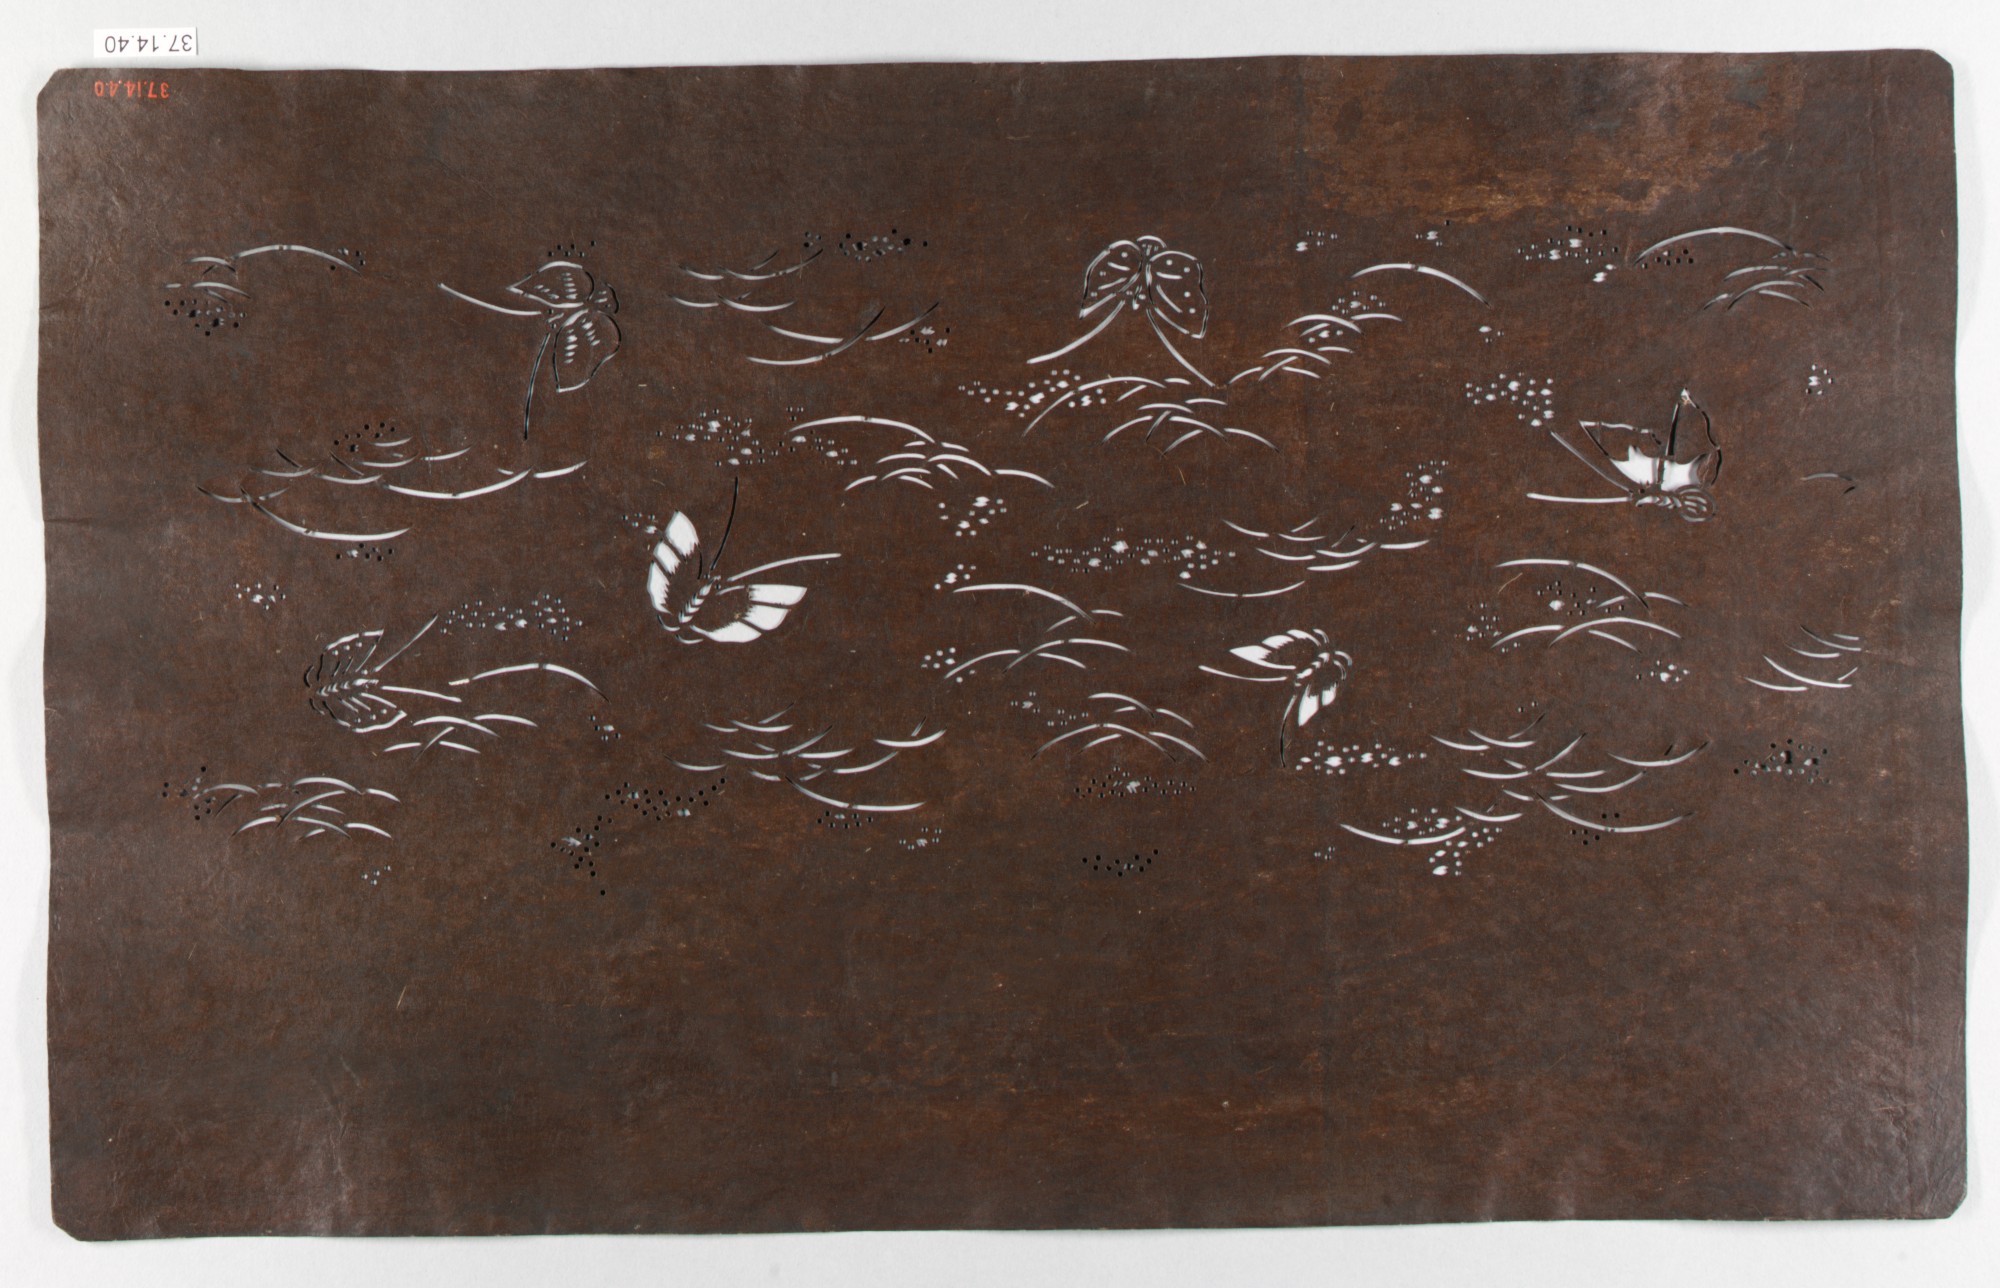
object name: stencil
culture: japanese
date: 1801-1833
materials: paper